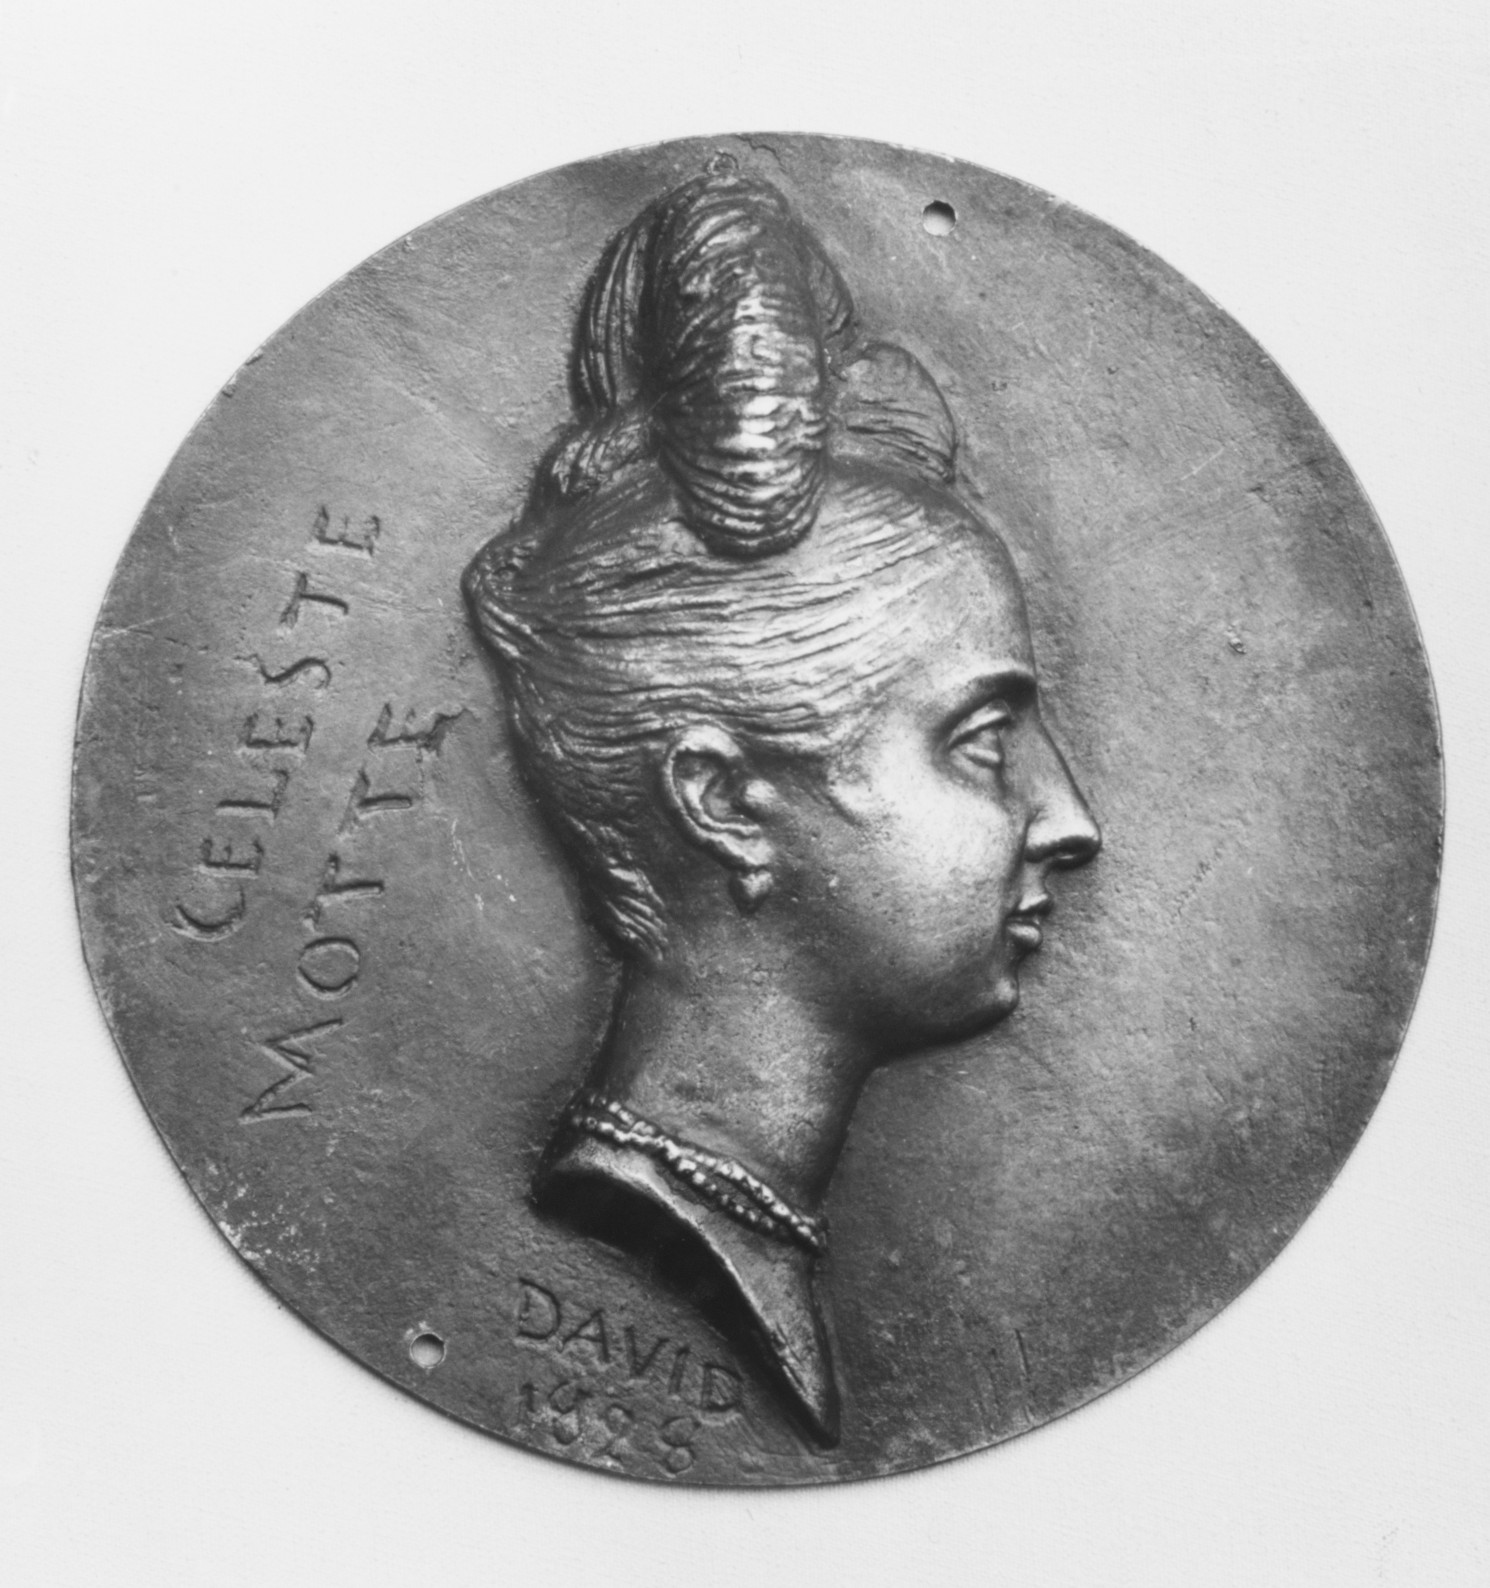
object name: medallion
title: Céleste Motte (afterwards wife if the designer and painter, Achille Devéria)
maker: pierre jean david d'angers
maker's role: artist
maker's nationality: french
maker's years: 1788-1856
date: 1828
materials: bronze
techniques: casting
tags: profiles,women